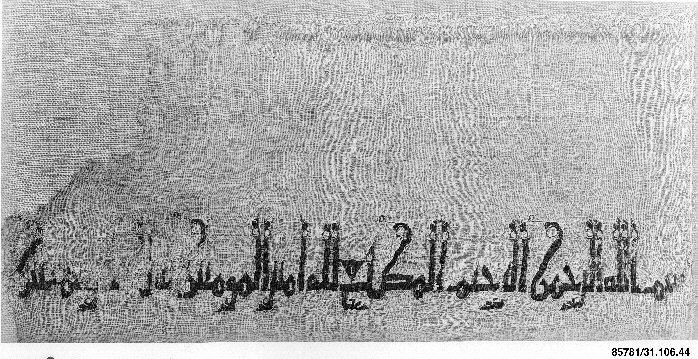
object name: textile fragment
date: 946-974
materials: linen, silk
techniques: weave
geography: egypt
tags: arabic